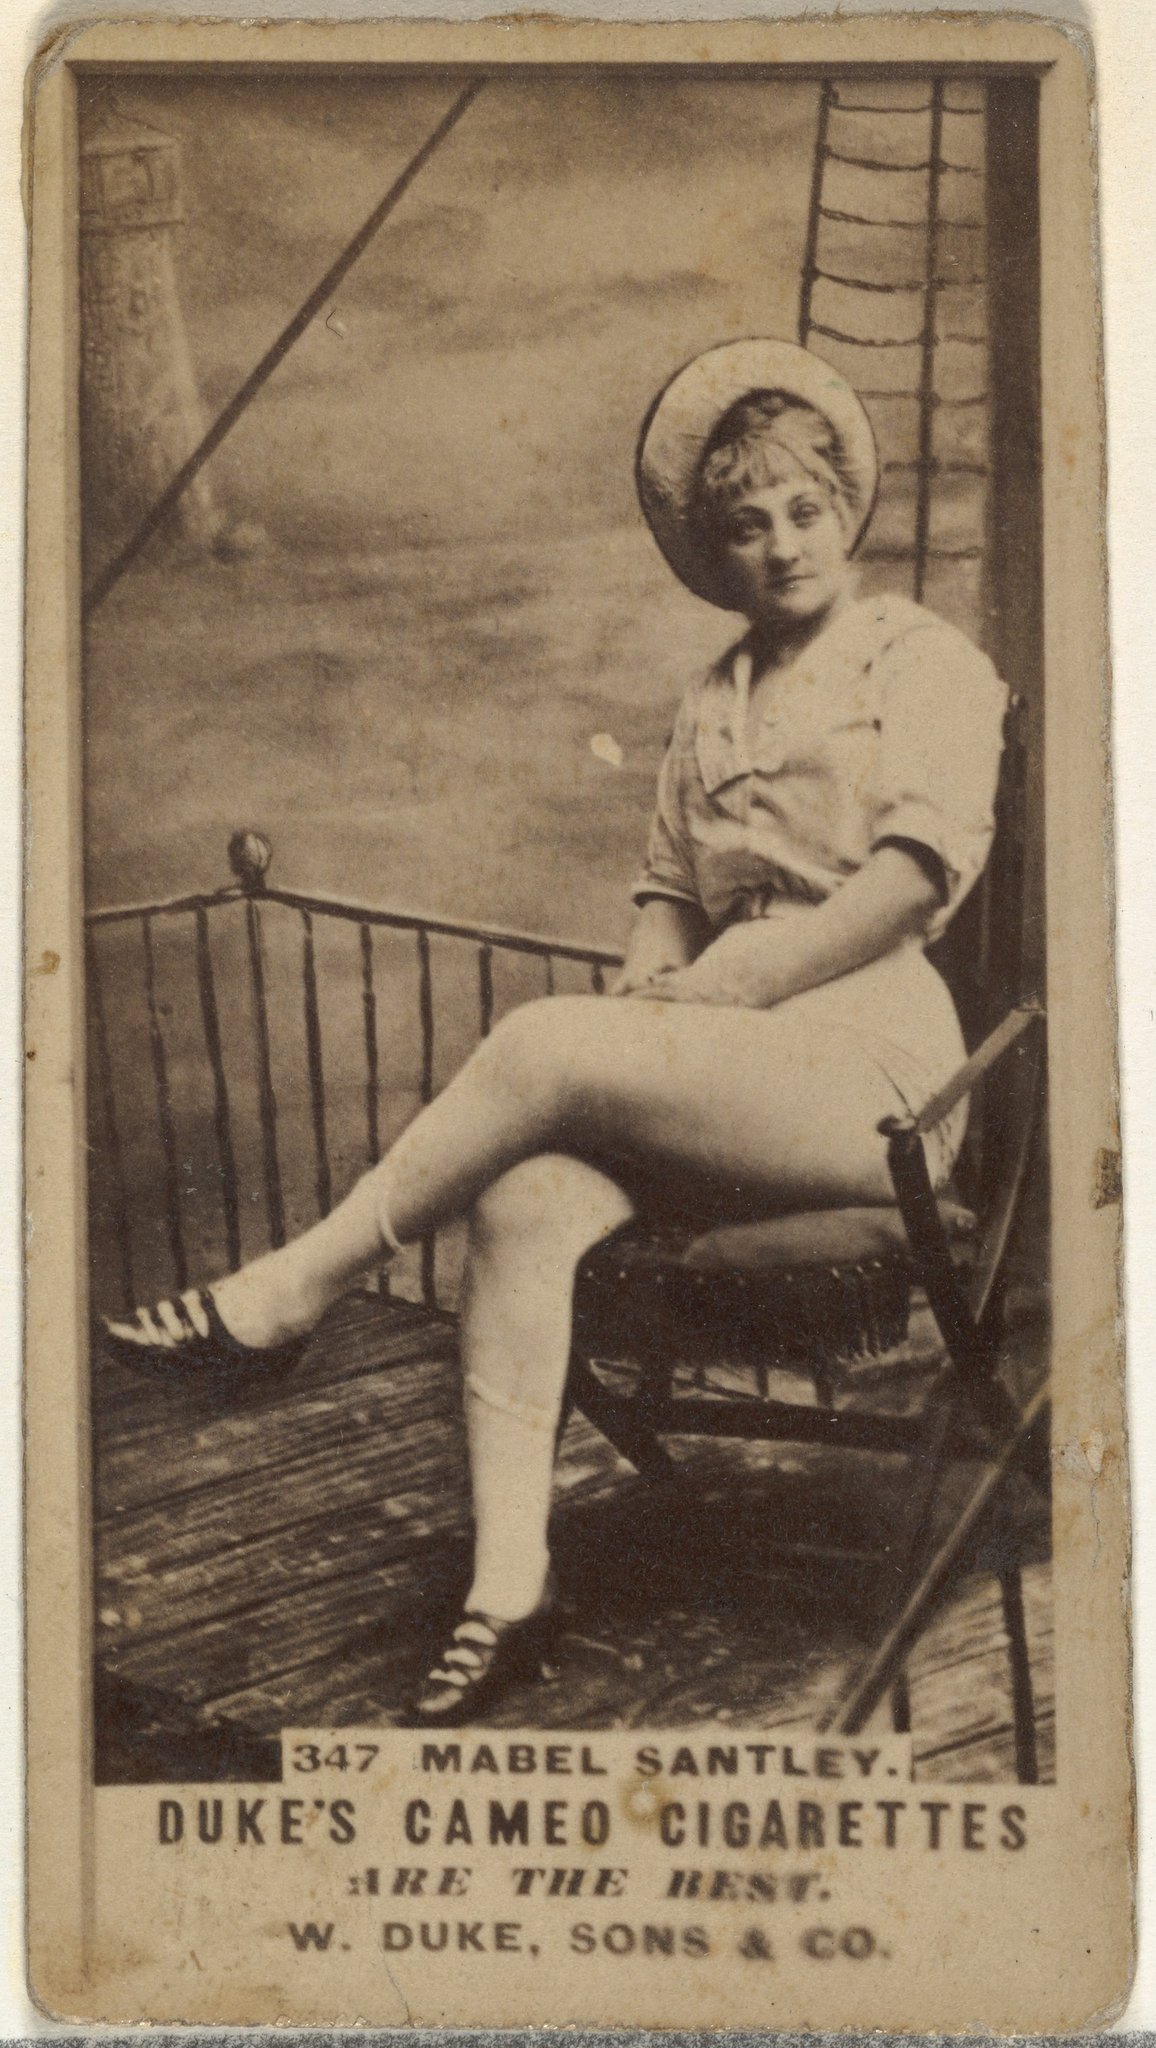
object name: photograph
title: Card Number 347, Mabel Santley, from the Actors and Actresses series (N145-5) issued by Duke Sons & Co. to promote Cameo Cigarettes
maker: w. duke, sons & co.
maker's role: publisher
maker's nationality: american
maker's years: 1870-1920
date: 1880-1889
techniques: albumen silver print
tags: portraits,women,actresses